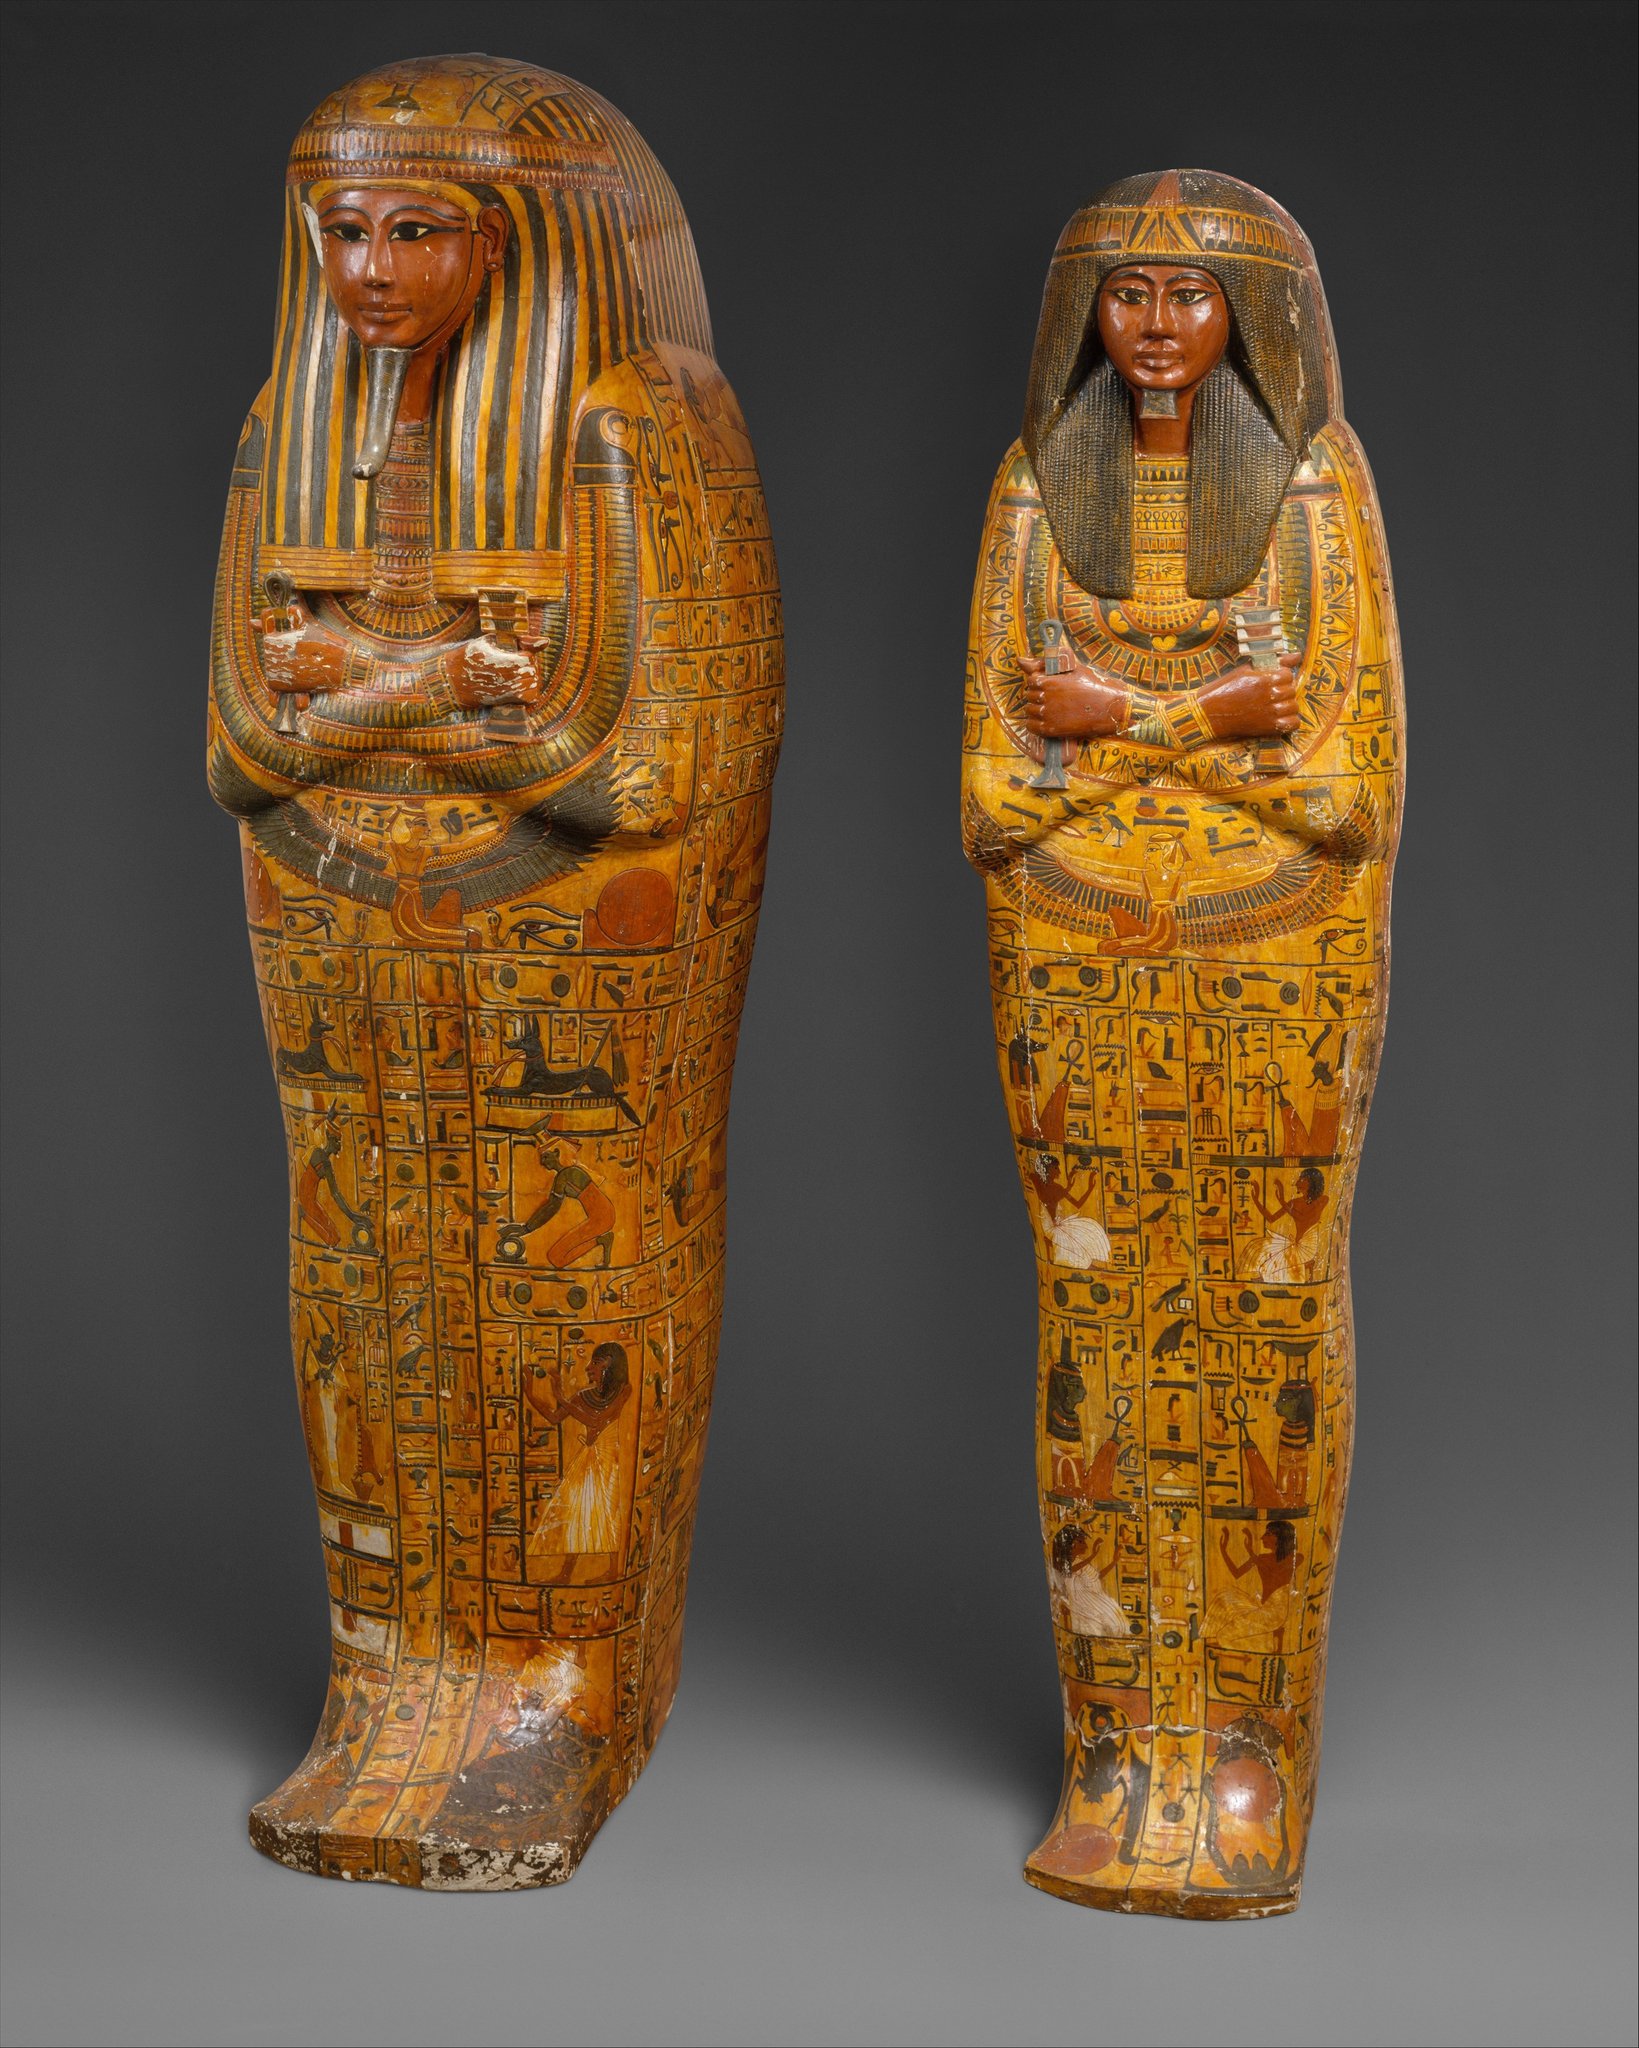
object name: coffin, khonsu, anthropoid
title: Khonsu's anthropoid coffins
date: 1279-1213 BCE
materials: gesso, paint, varnish, wood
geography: egypt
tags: men,coffins